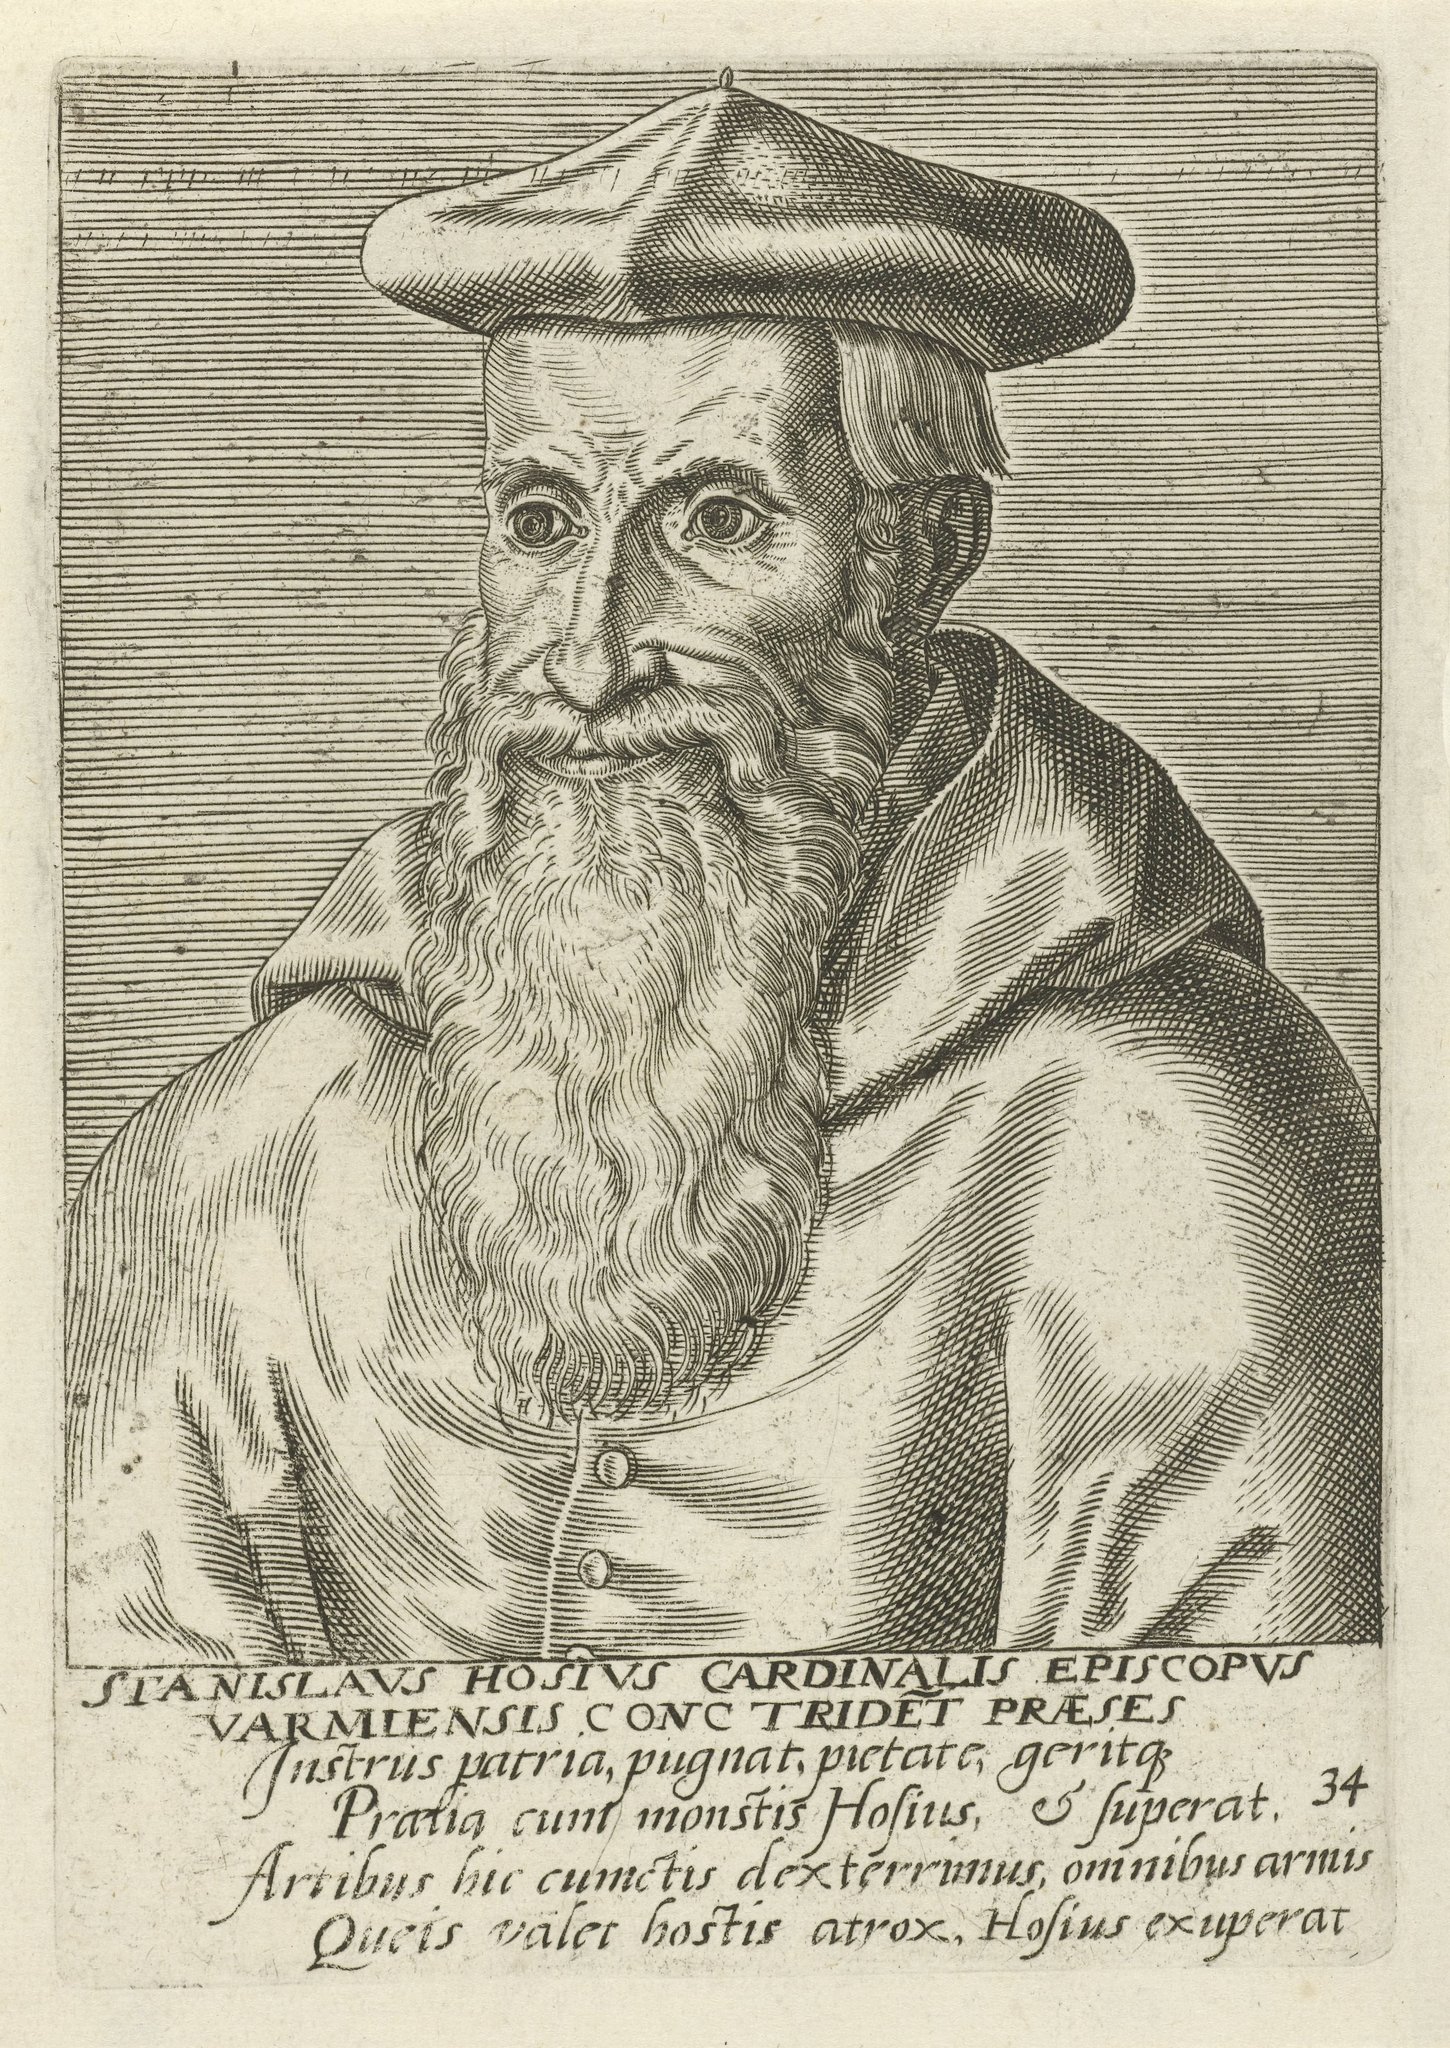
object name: print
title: Stanislavs Hosivs Cardinalis Episcopvs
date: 1572-1612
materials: paper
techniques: engraving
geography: antwerp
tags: rome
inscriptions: collector's mark: Lugt 2228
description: Portret van Stanislaus Hosius, een Poolse kardinaal. Buste naar links.